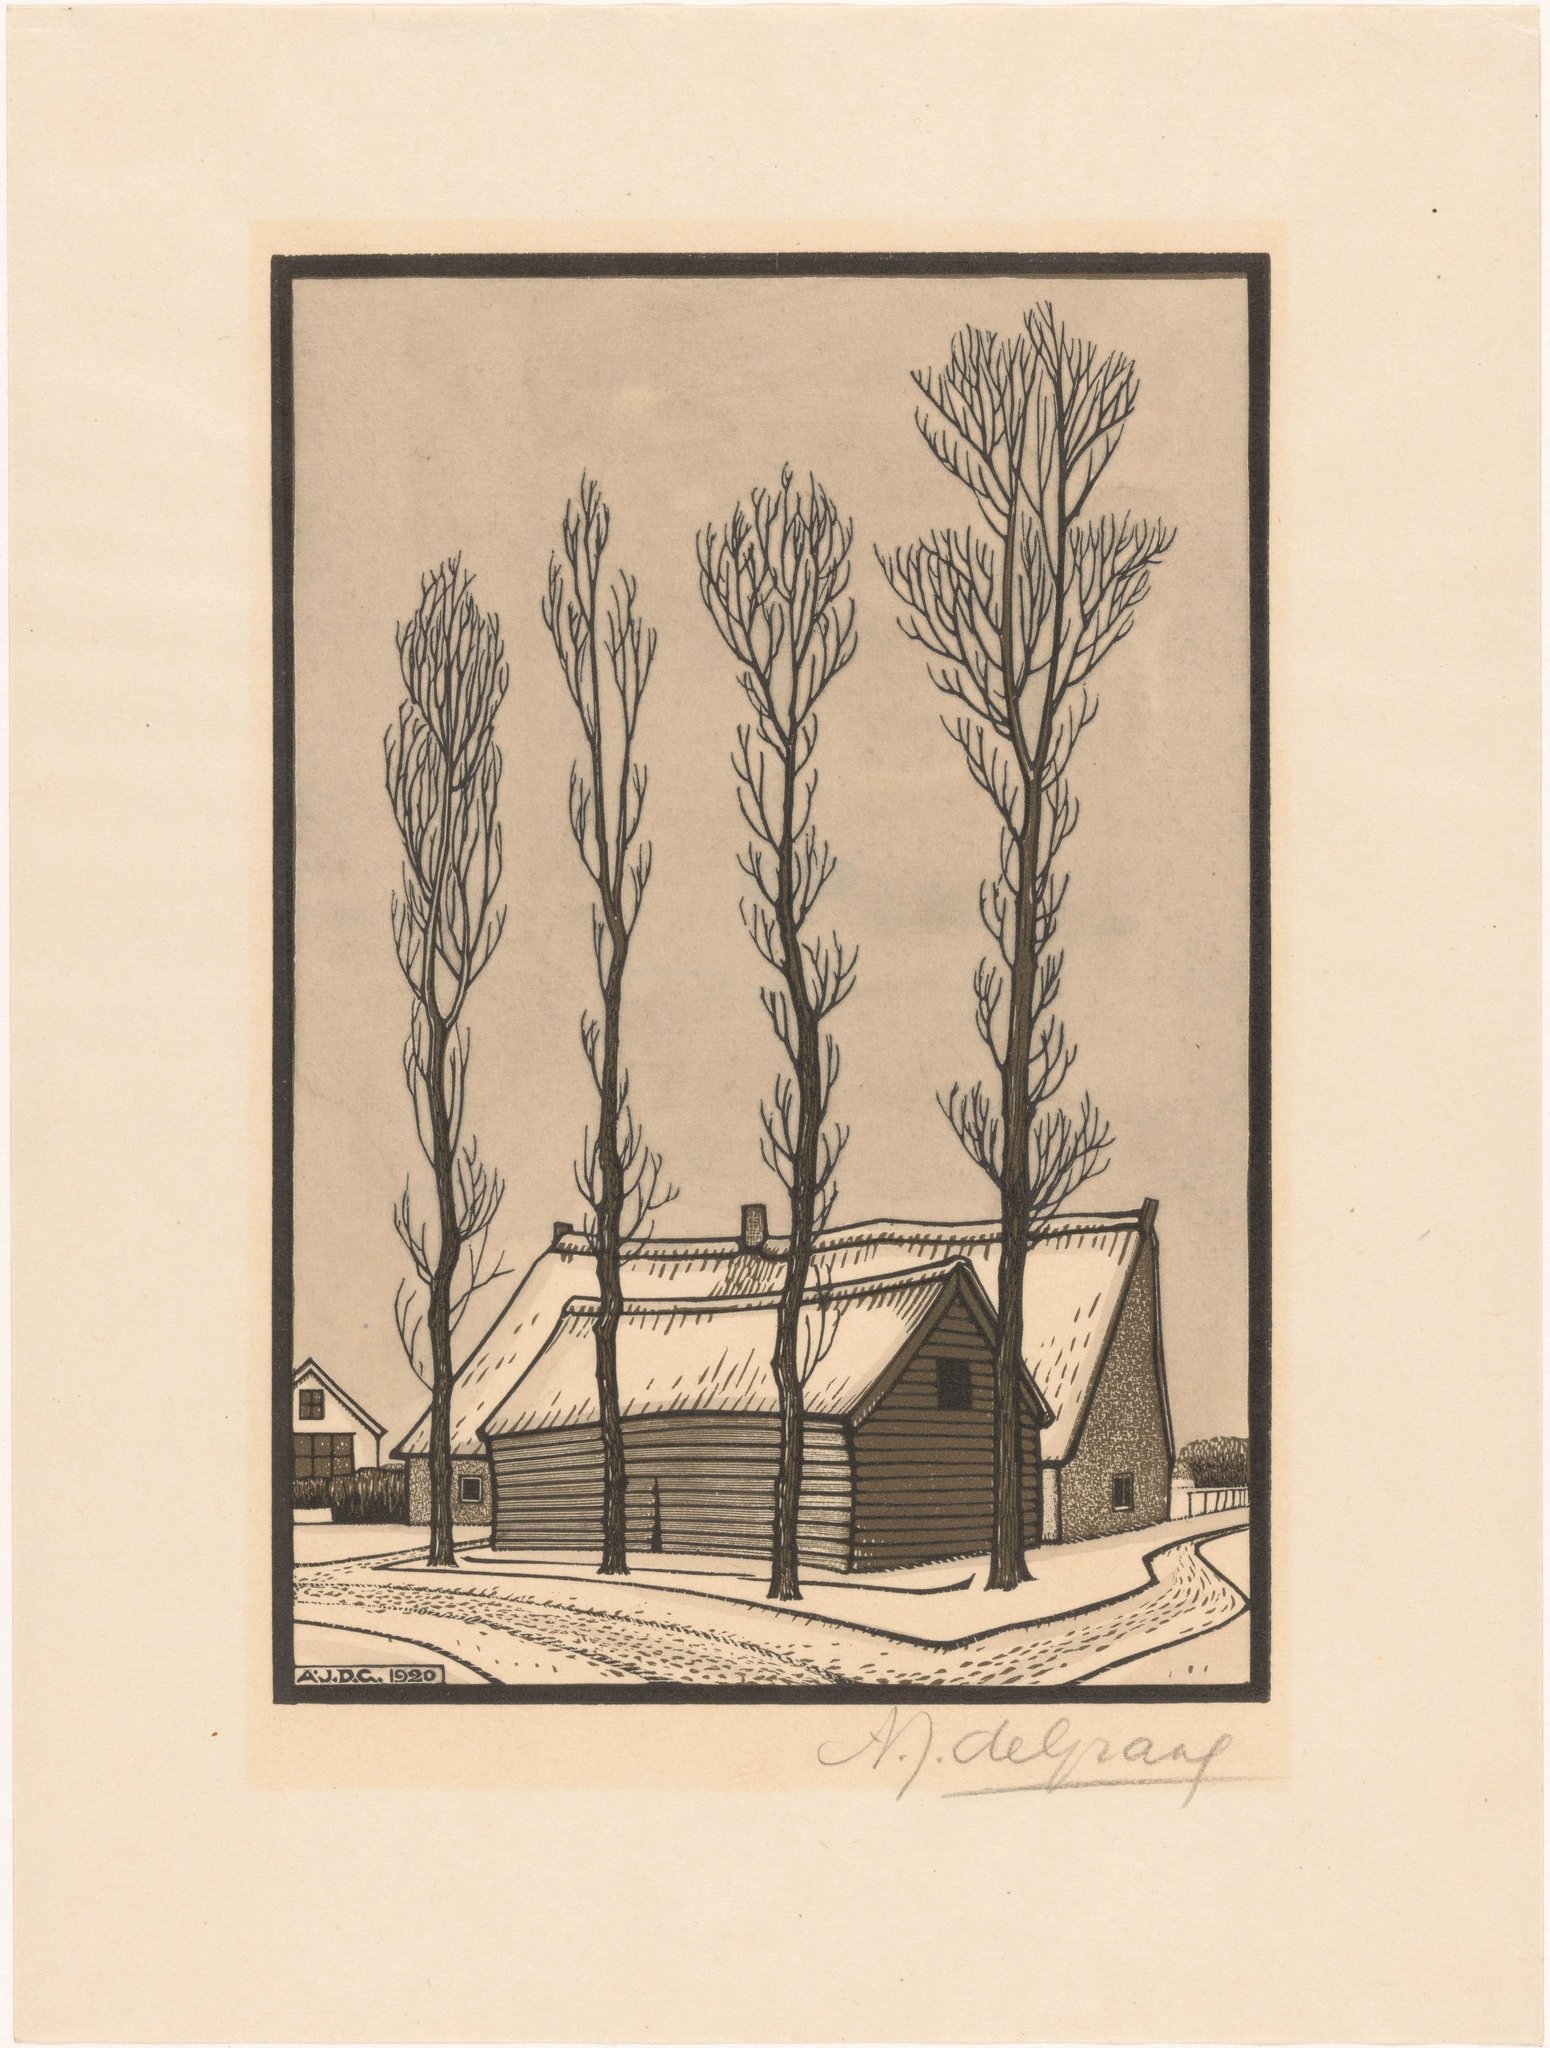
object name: print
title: Winter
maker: julie de graag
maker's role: draughtsman, print maker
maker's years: 1877-1924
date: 1920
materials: paper, watercolor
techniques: hand coloring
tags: winter landscape; landscape symbolizing winter (the four seasons of the year), farm or solitary house in landscape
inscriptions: collector's mark: Lugt 2228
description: Vier kale bomen bij een boerderij met een schuur en een stal in een besneeuwd landschap.